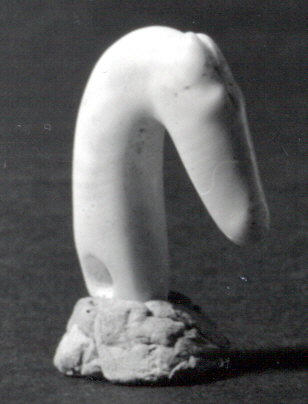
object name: bead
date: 7333-7001 BCE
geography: syria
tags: animals